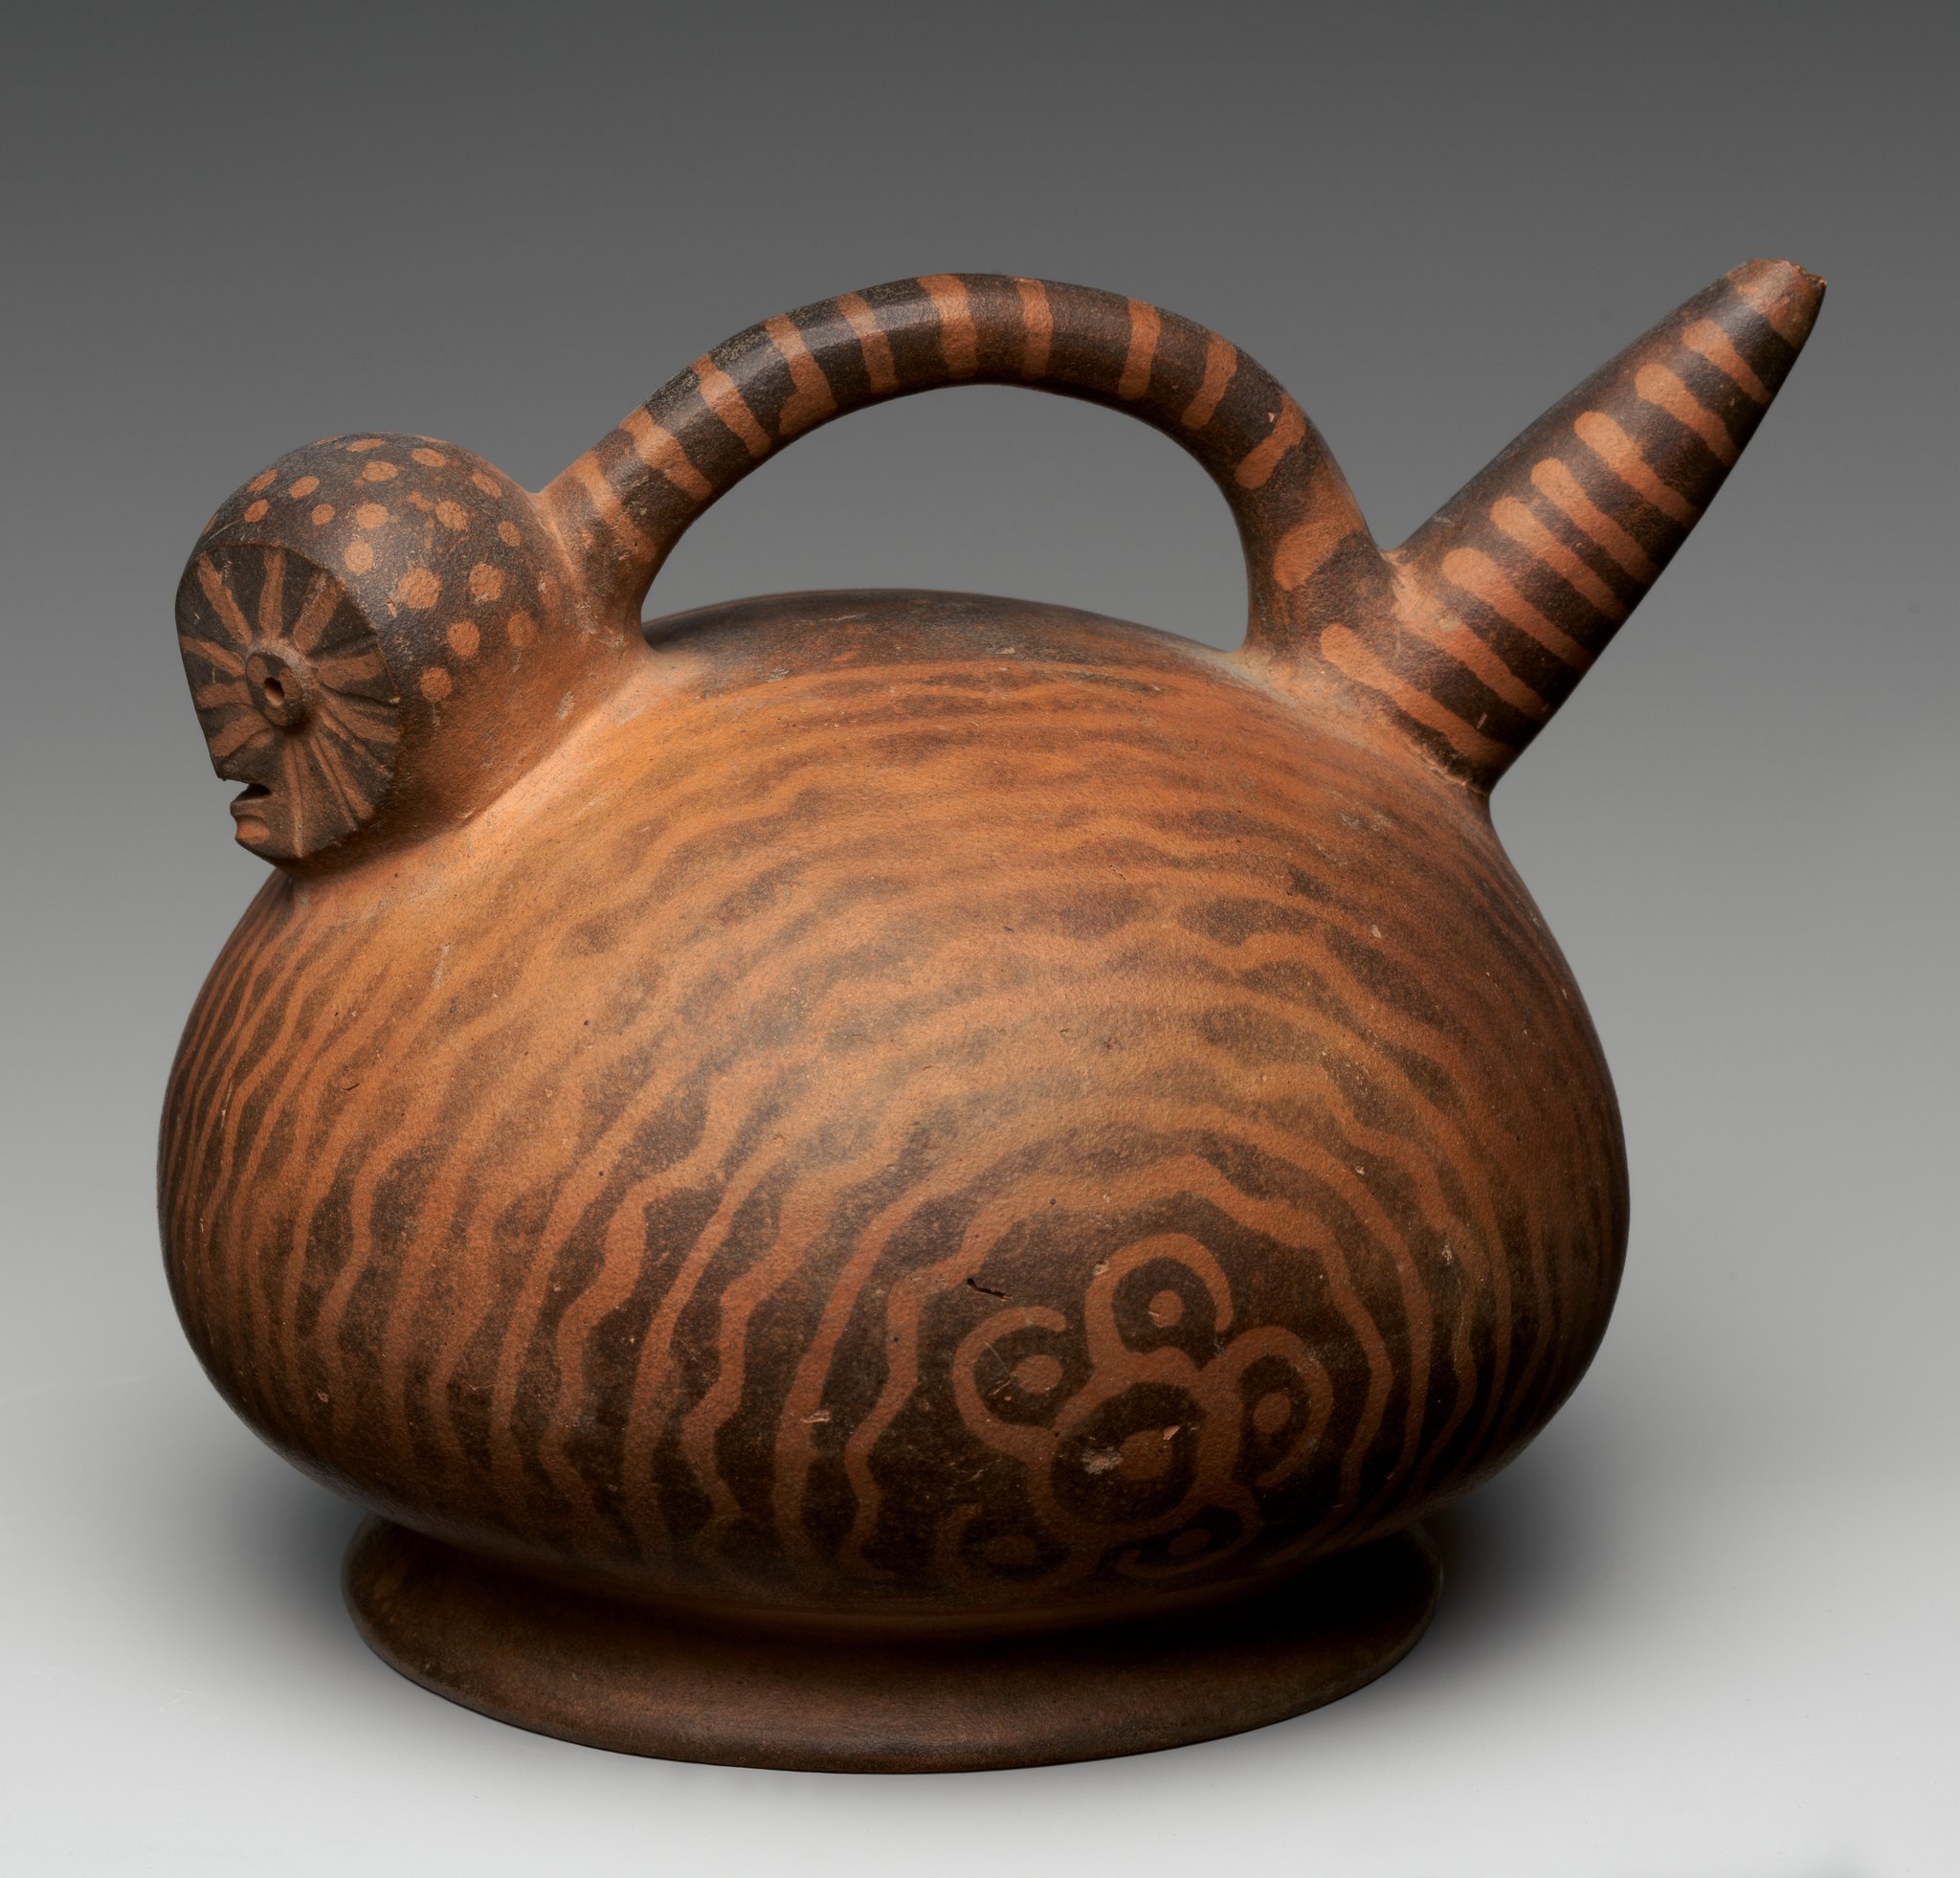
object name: bottle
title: Spout-and-bridge bottle with owl head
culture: virú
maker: virú artist(s)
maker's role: artist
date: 150 BCE-500 CE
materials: ceramic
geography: peru